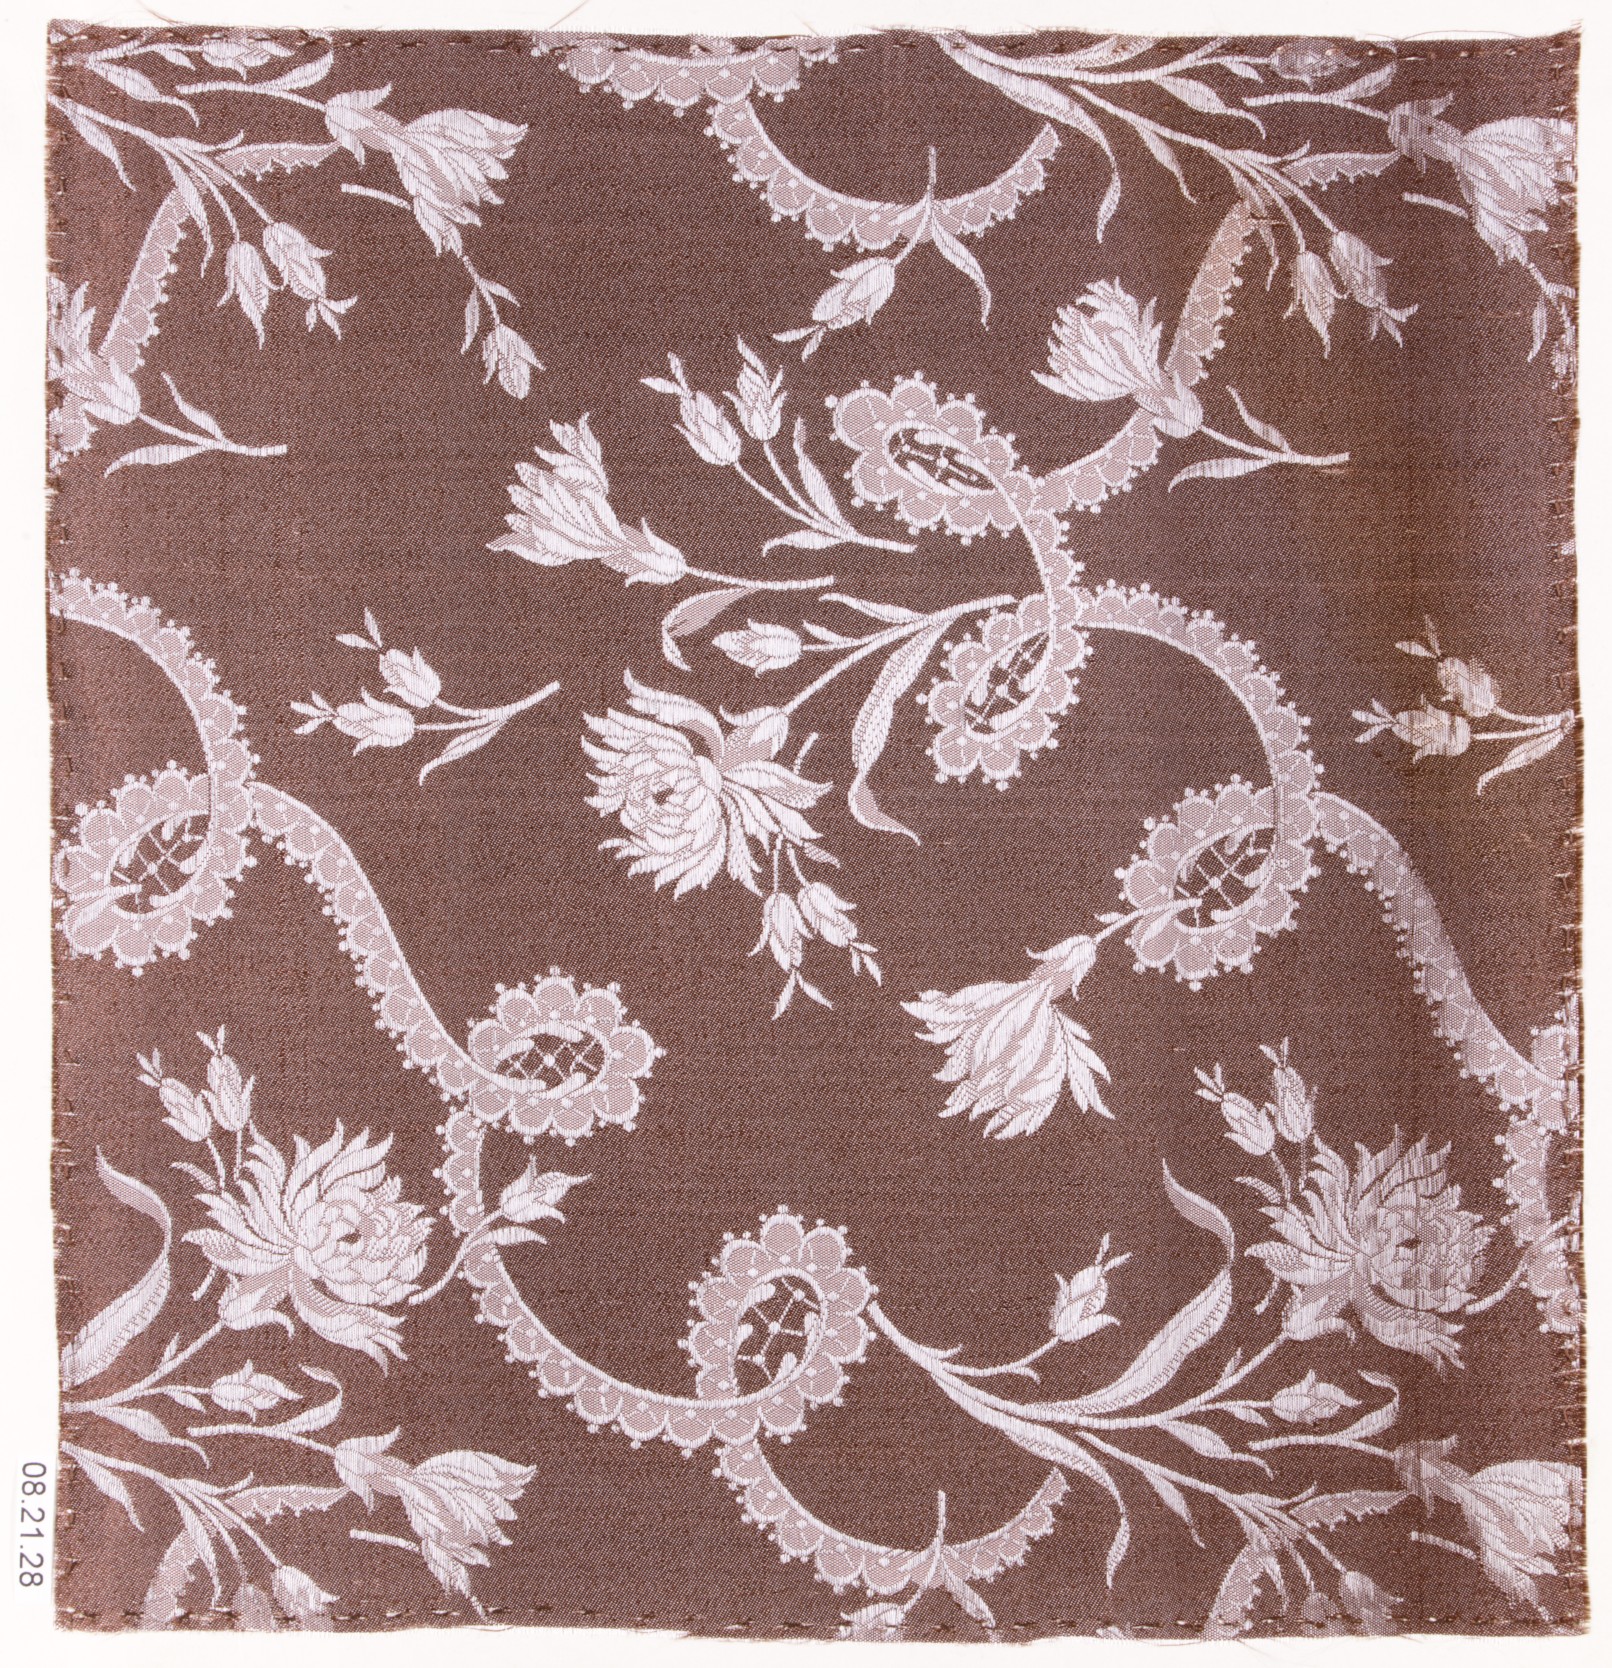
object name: textile sample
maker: Anonymous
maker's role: designer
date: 1900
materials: silk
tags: flowers